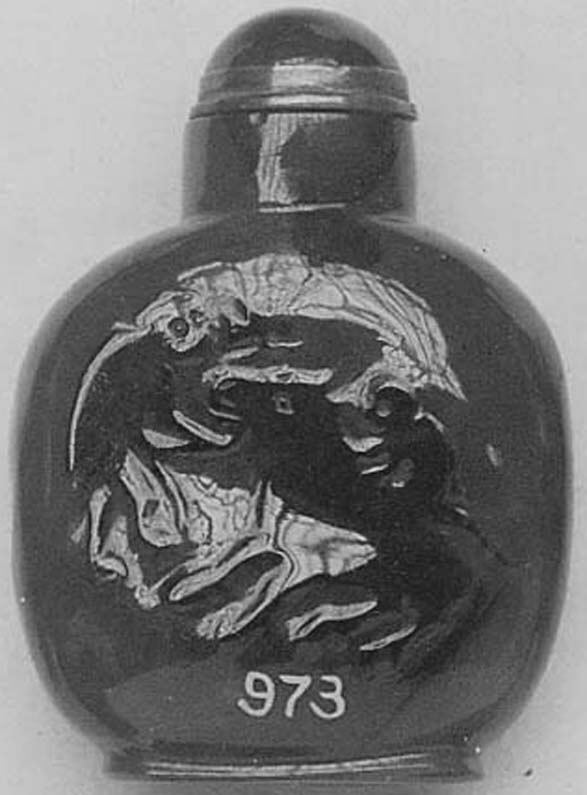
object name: snuff bottle with stopper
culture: chinese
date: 1701-1900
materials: stone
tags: horses,monkeys